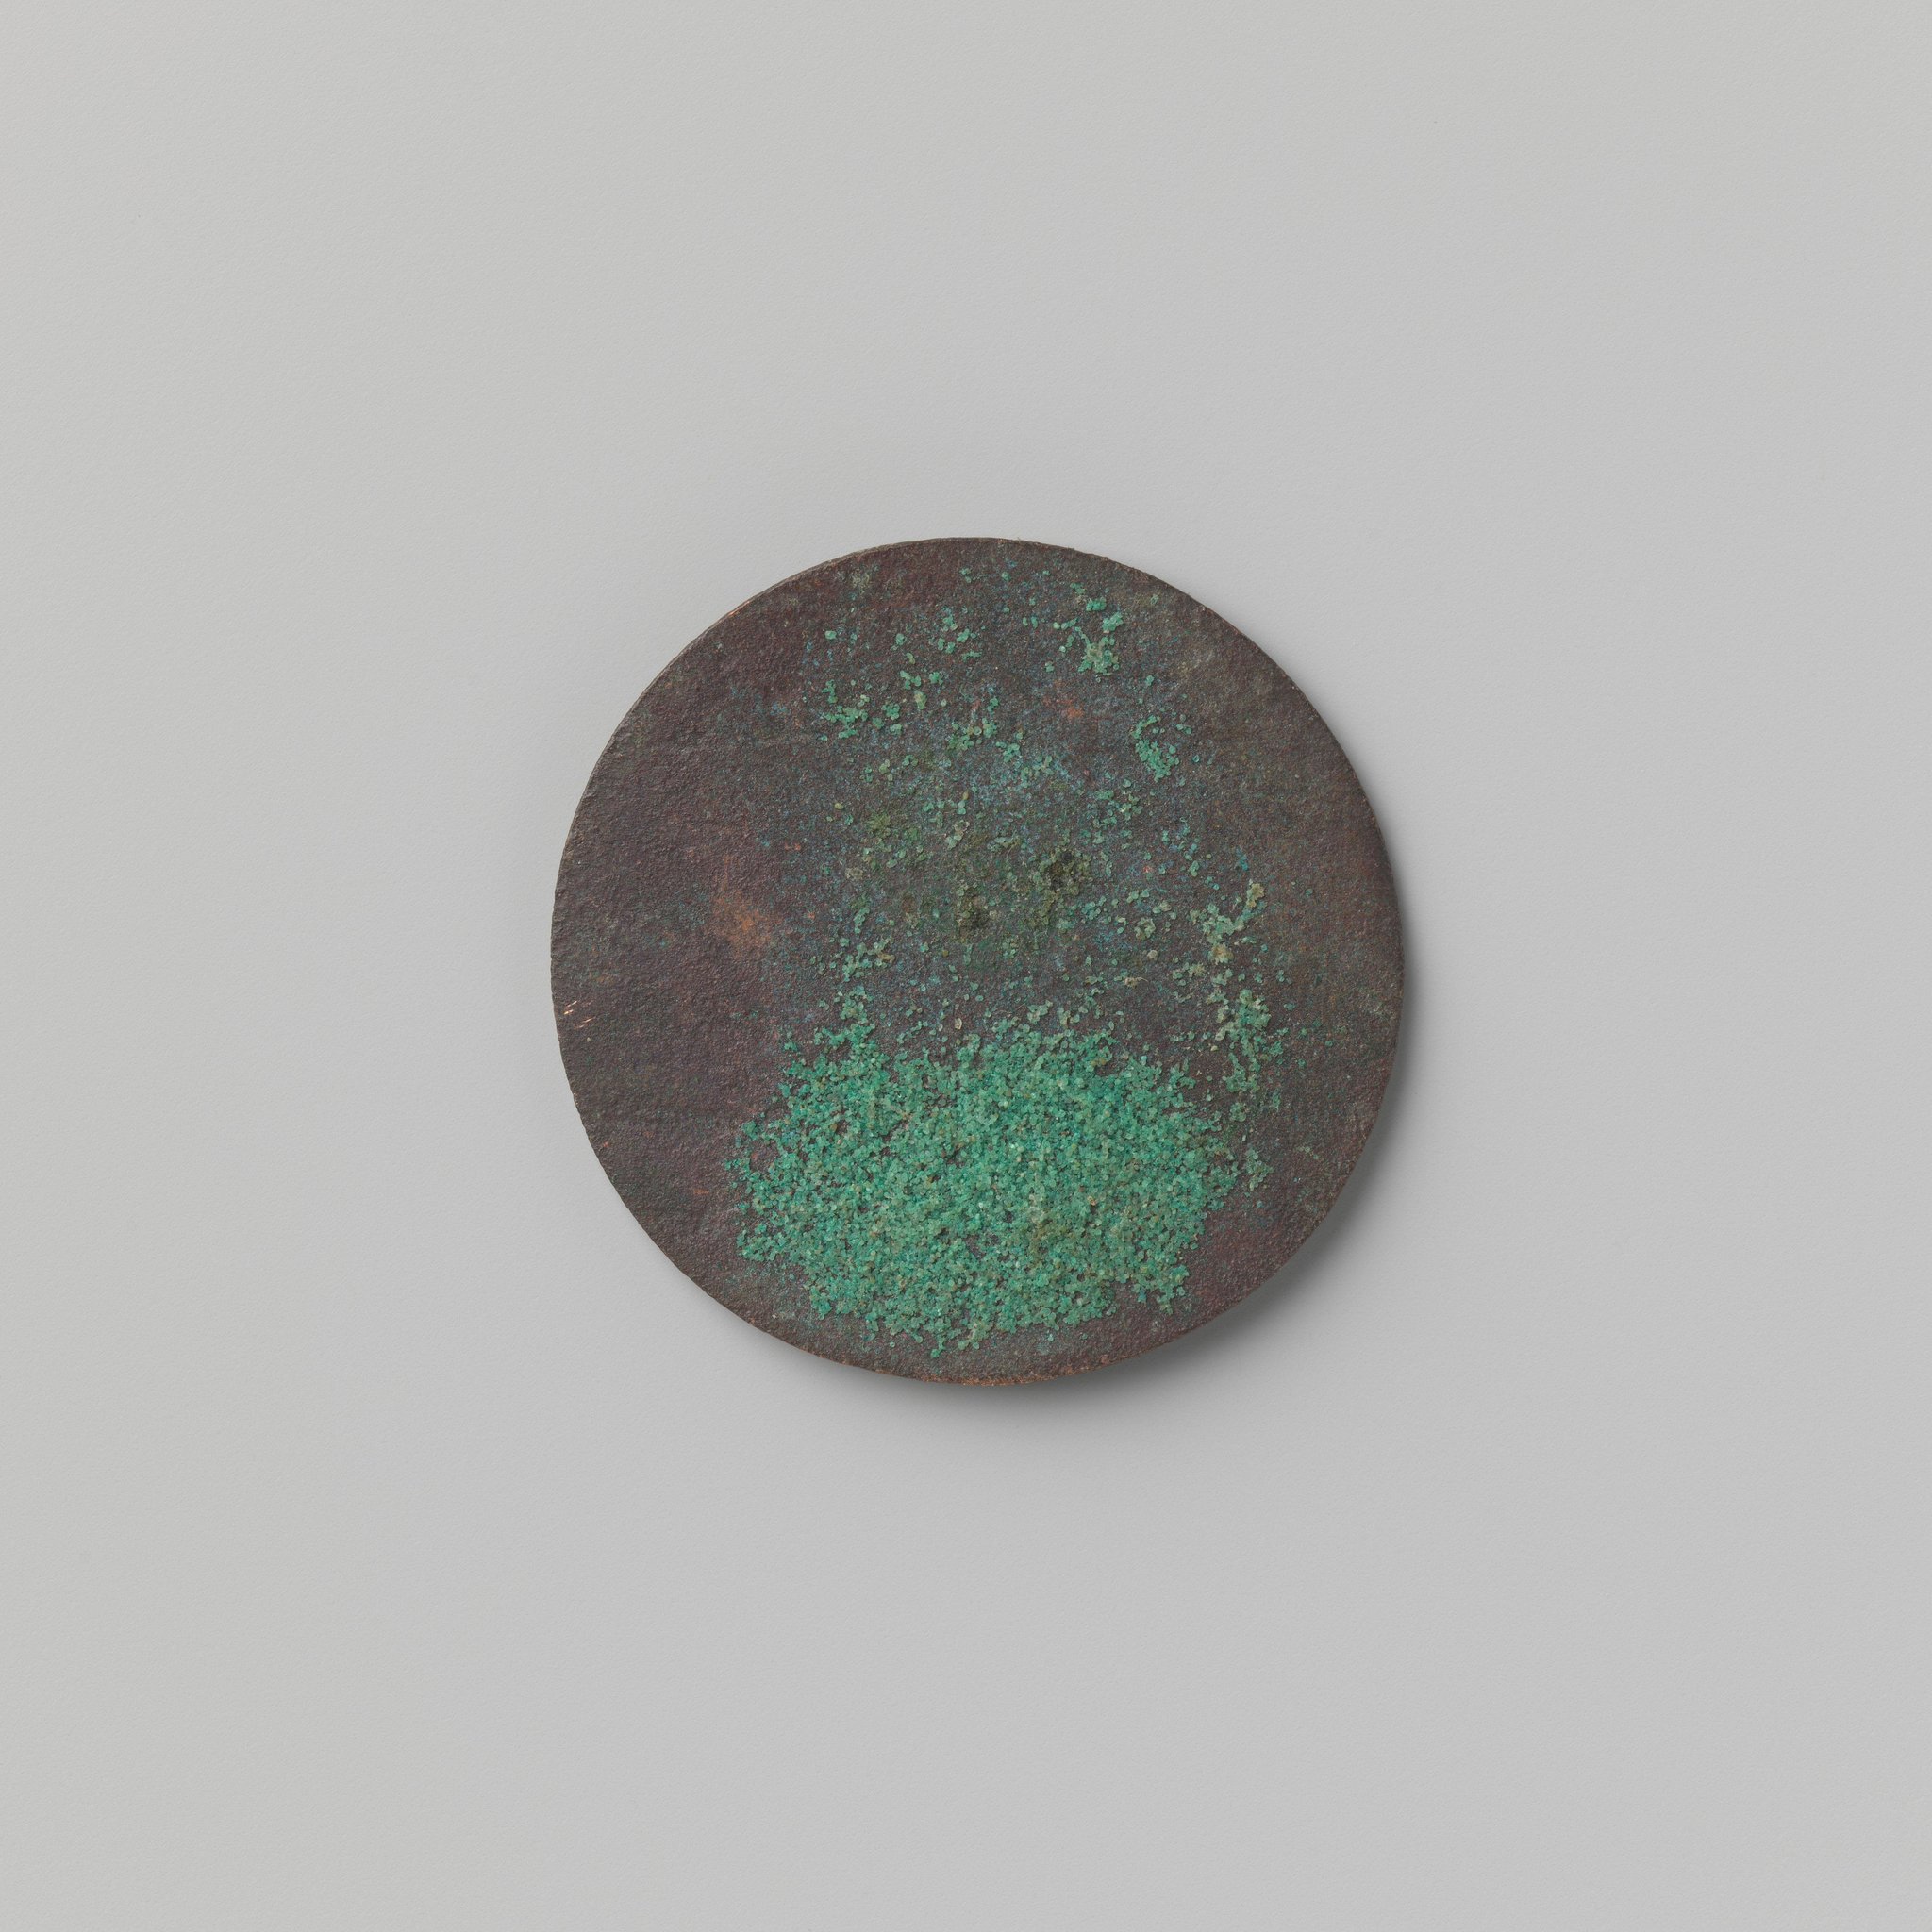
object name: tien real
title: Rondel (ongeslagen muntplaatje)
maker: Anonymous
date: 1700-1800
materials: copper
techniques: striking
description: Rondel, gevonden op het strand van Terschelling, waarschijnlijk van Zweedse oorsprong en in Göteborg of Hamburg ingeladen in een schip dat – op weg naar Lissabon – nabij Terschelling zonk.